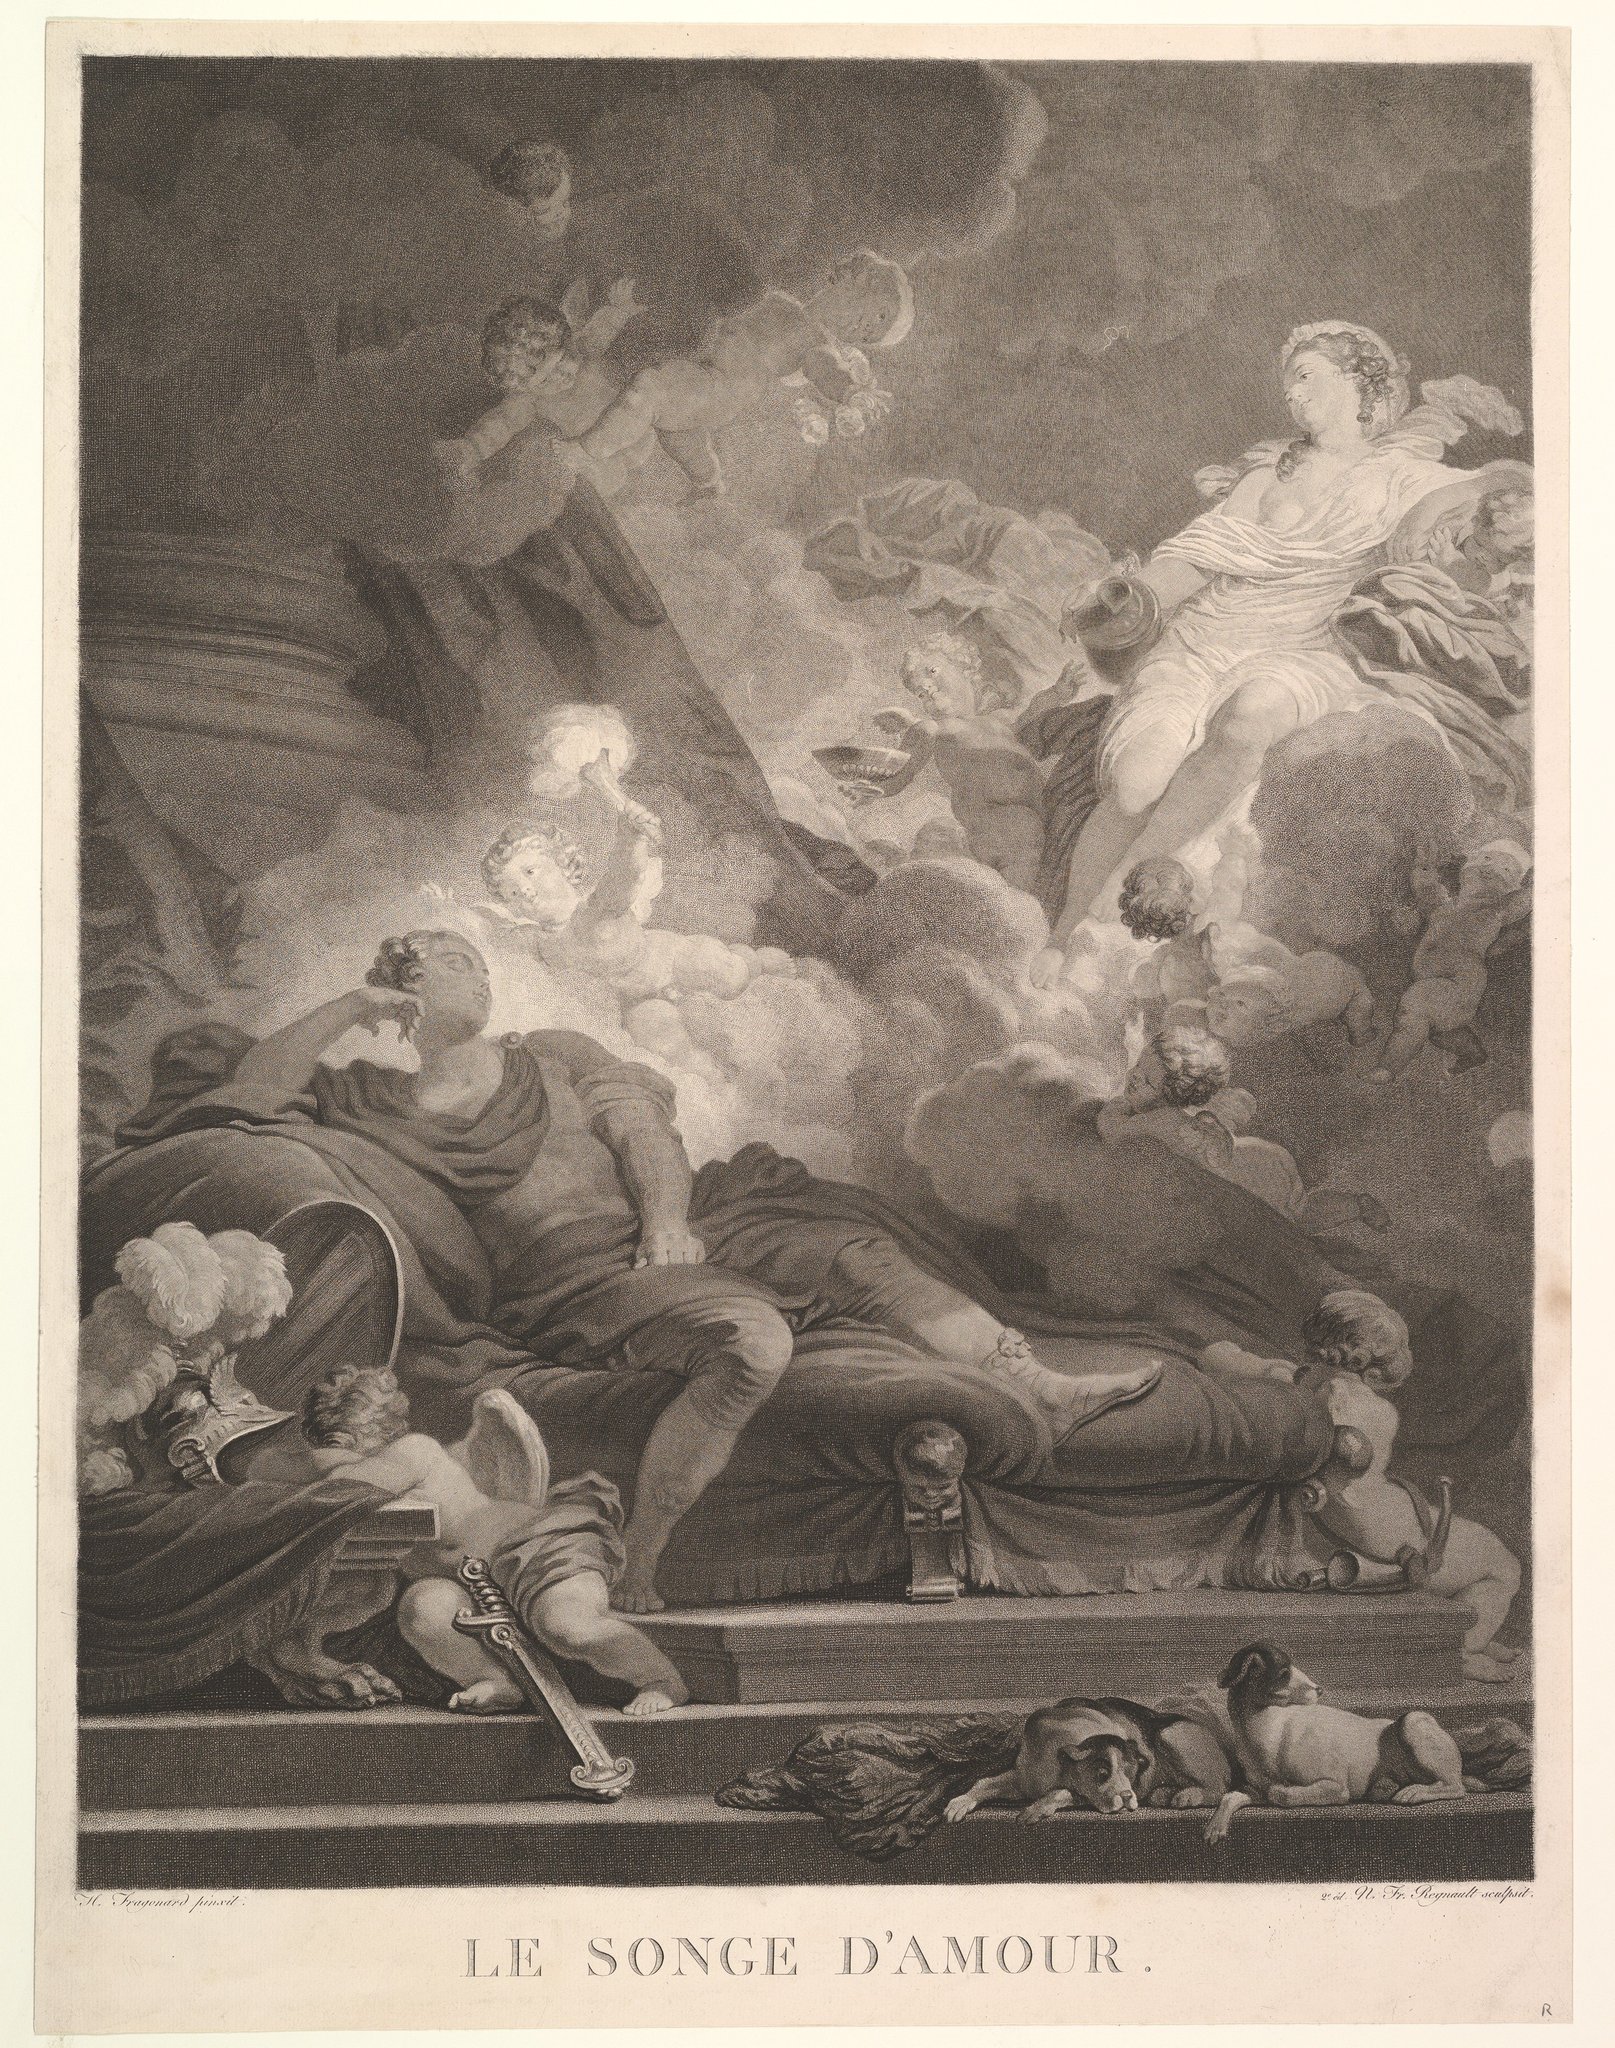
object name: print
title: Le Songe d'Amour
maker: nicholas françois regnault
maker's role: engraver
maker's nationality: french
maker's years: 1746-1810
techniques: etching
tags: men,women,putti,dogs